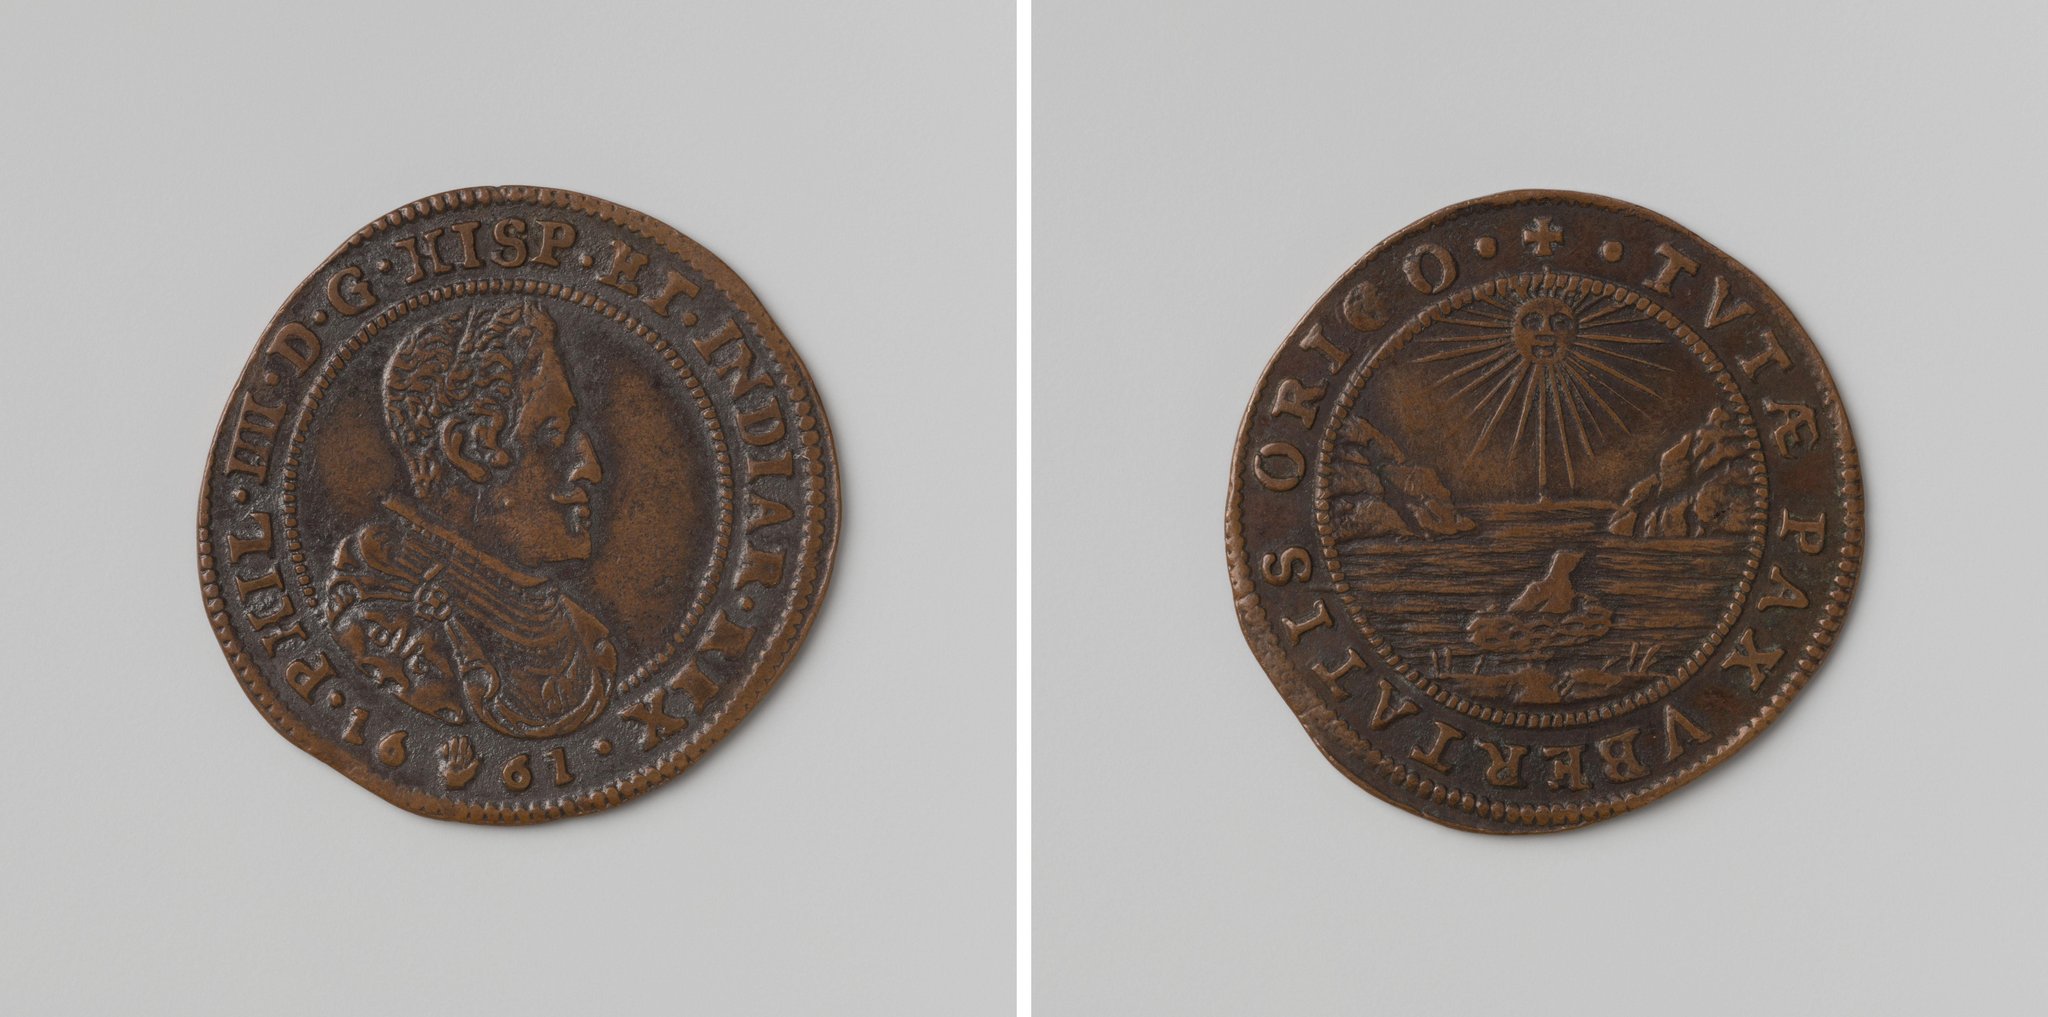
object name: jeton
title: Vrede van de Pyreneeën tussen Frankrijk en Spanje, rekenpenning geslagen ter ere van Filips IV, koning van Spanje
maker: Anonymous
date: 1661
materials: copper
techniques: striking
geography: antwerp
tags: filips iv (koning van spanje), france, spain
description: Koperen penning. Voorzijde: borststuk man binnen omschrift. Keerzijde: ijsvogel zittend in zijn nest, dat op rustige zee drijft, beschenen door dtralende zon binnen omschrift